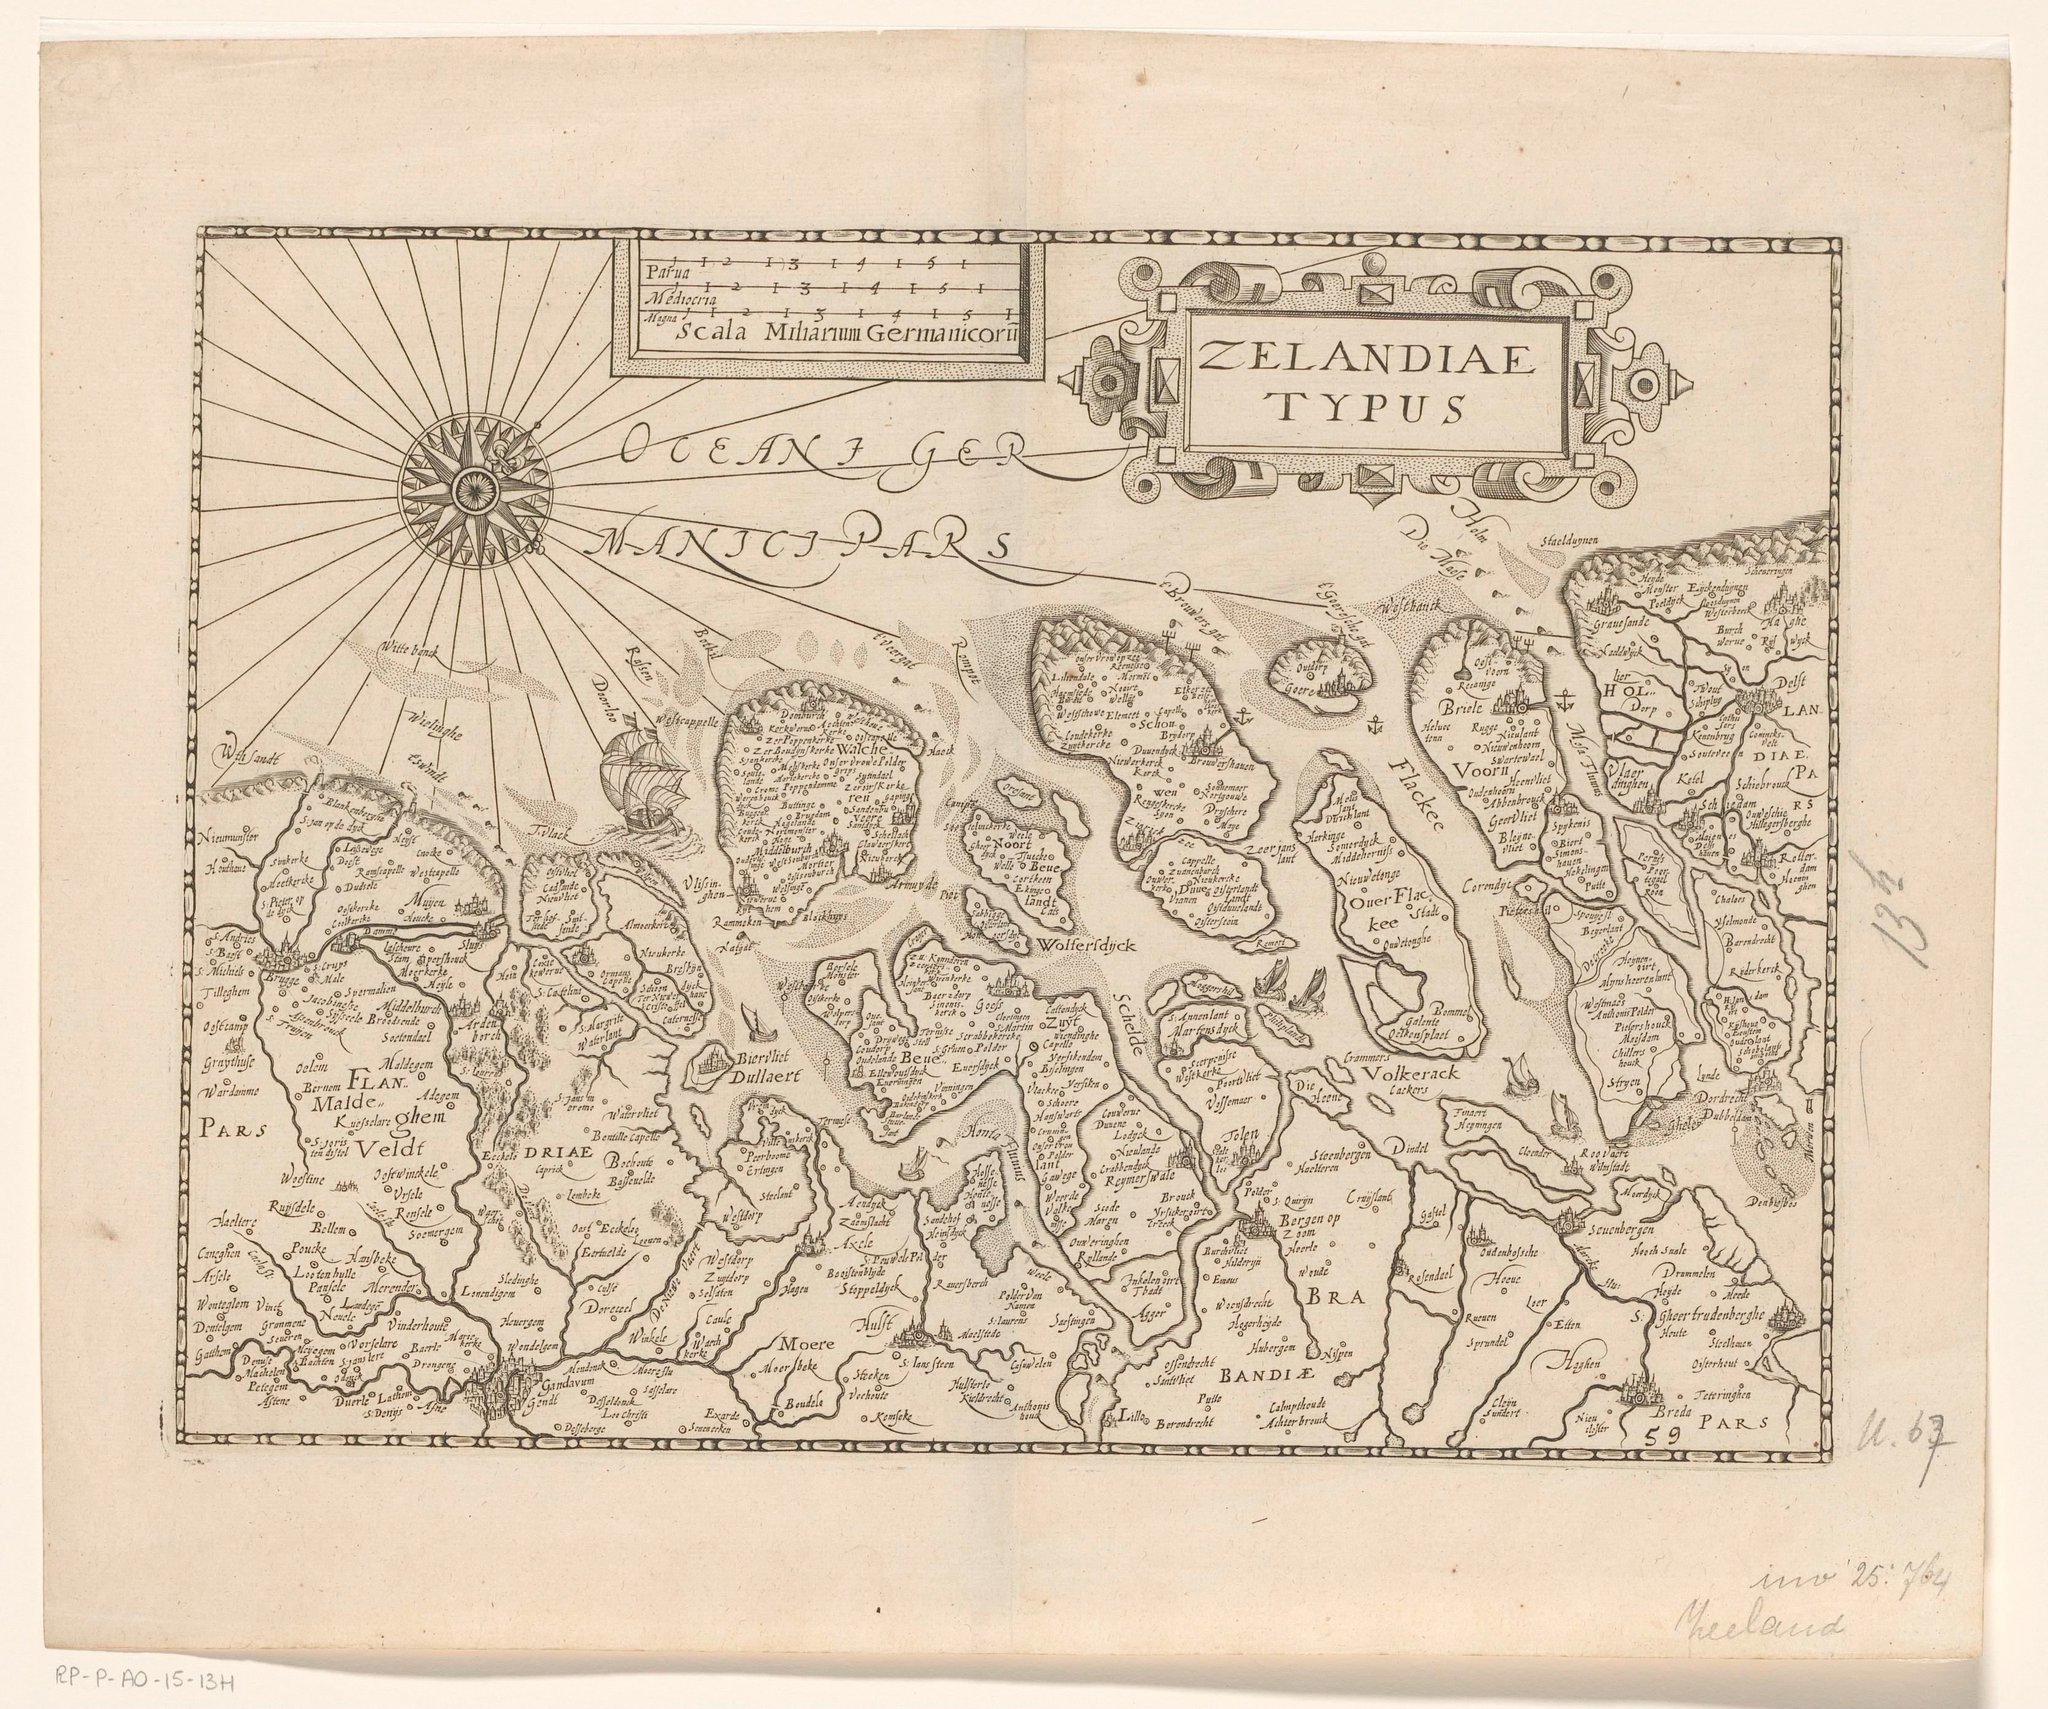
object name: book illustration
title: Zelandiae typus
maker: Anonymous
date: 1612-1648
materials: paper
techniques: engraving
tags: maps of separate countries or regions, zeeland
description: Deze staat van prent voor het eerst ook gebruikt in: Guicciardini, Lodovico. Beschryvinghe van alle de Neder-landen, anderssins ghenoemt Neder-Duytslandt (…). Amsterdam: Willem Janszoon Blaeu, 1612. Hierna is deze prent tot 1648 nog gebruikt in latere uitgaven van deze publicatie, uitgegeven door Blaeu en daarna door Janssonius. Uit welke uitgave het huidige exemplaar precies komt is niet na te gaan.